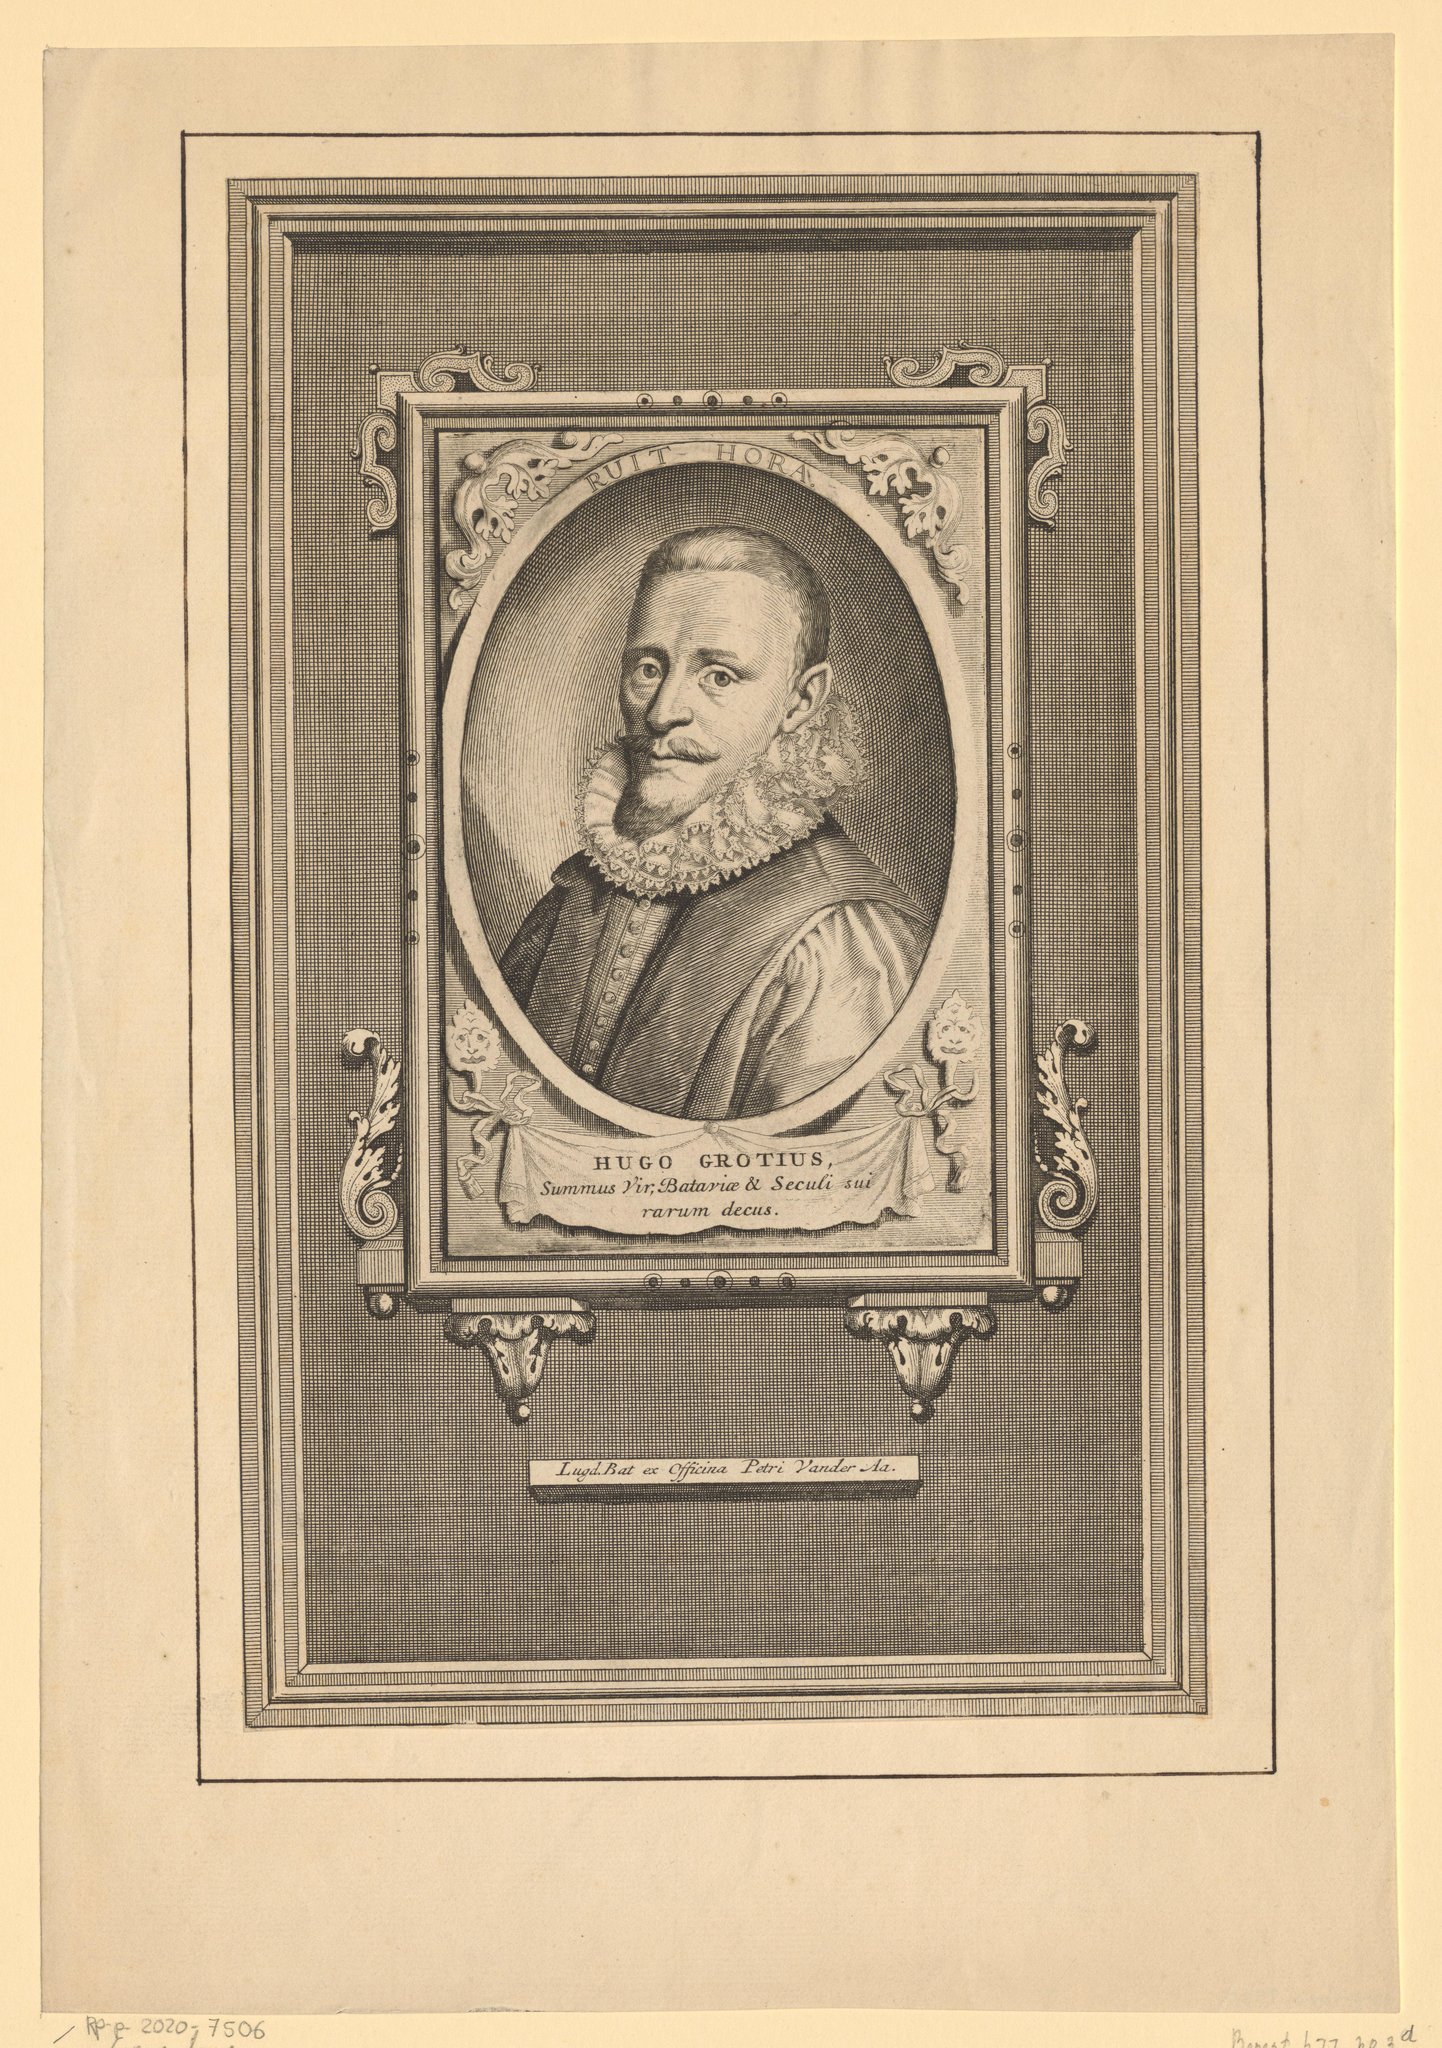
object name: print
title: Portret van Hugo de Groot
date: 1668-1733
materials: paper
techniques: engraving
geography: leiden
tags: delft, hugo de groot, theologian, historical persons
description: Eerdere staat gebruikt in: Meursius, Joannes. Illustris Academia Lugd.-Batava. Leiden: Andries Clouck, 1613. Prent mogelijk gebruikt in: Fundatoris, Curatorum et Professorum celeberrimorum aliorumque illustrium virorum, quorum gratia, favore, cura, doctrinaque Academia Lugduno-Batava incepit, auctaque et ornata est, effigies. Nec non urbis, Academiae ejusque Horti, Templorum notabiliorumque publicorum aedificiorum prospectus. Leiden: Pieter van der Aa (I), [1716].